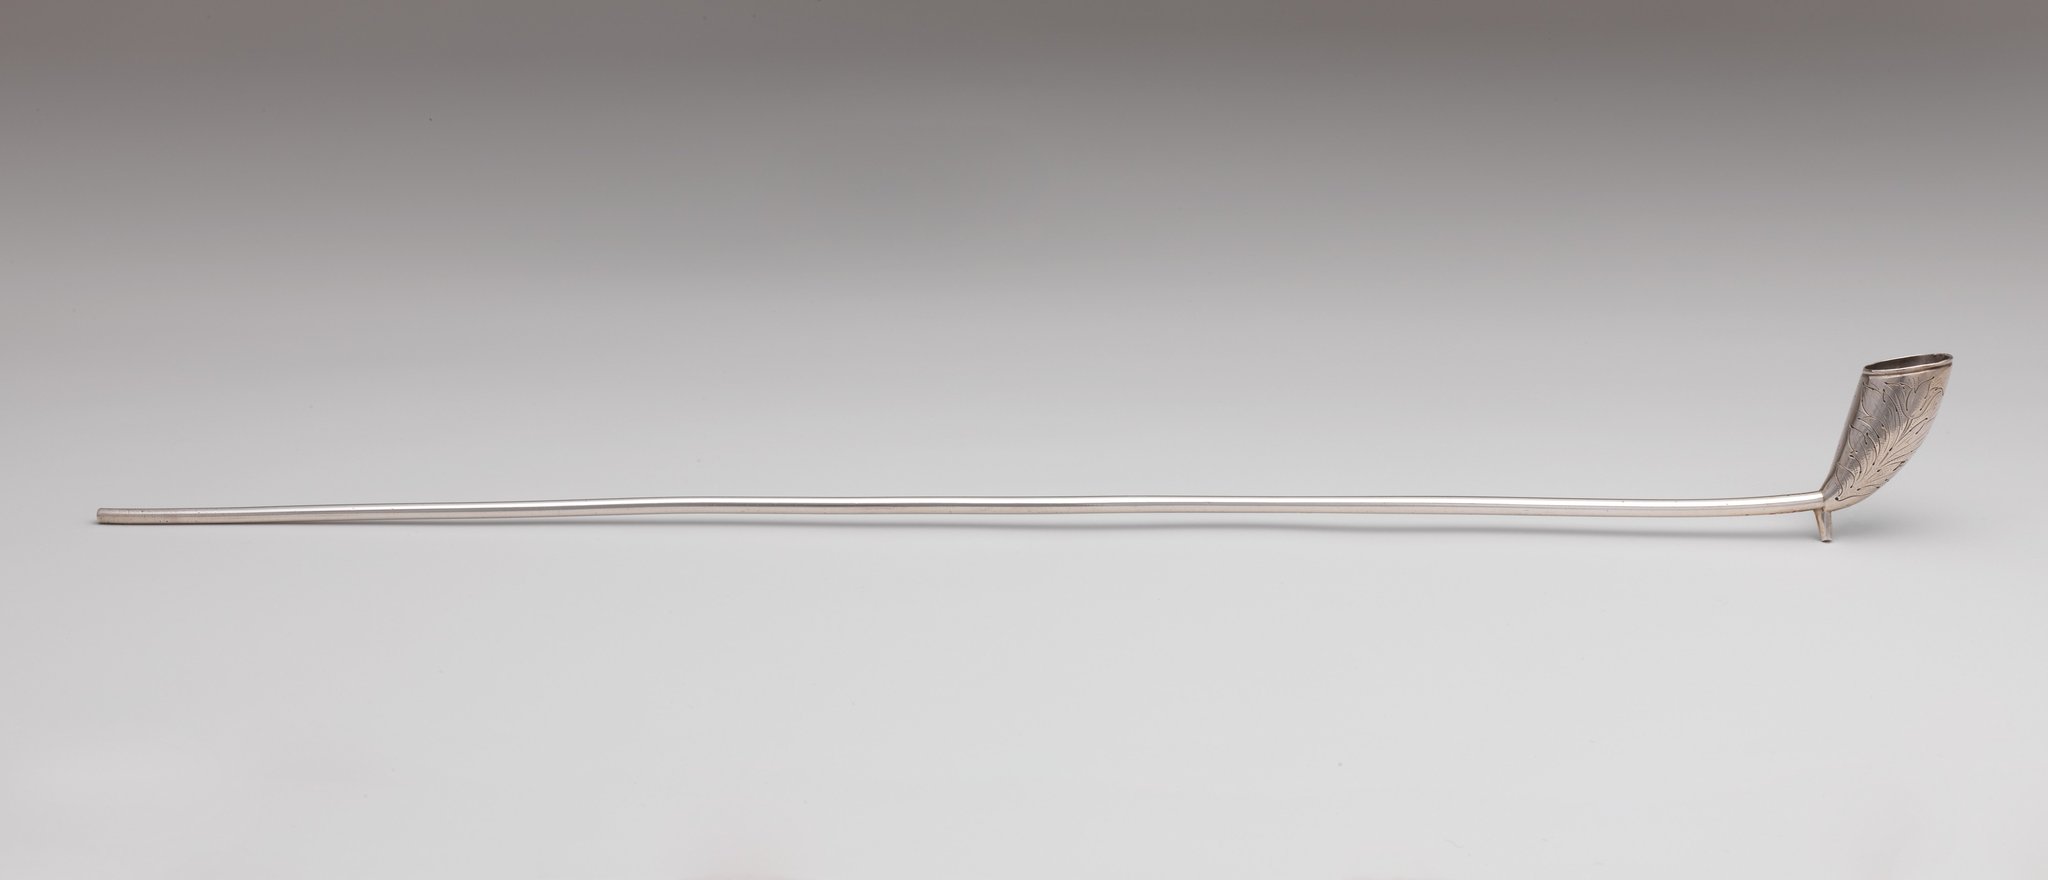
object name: pipe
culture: american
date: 1710-1735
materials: silver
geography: united states